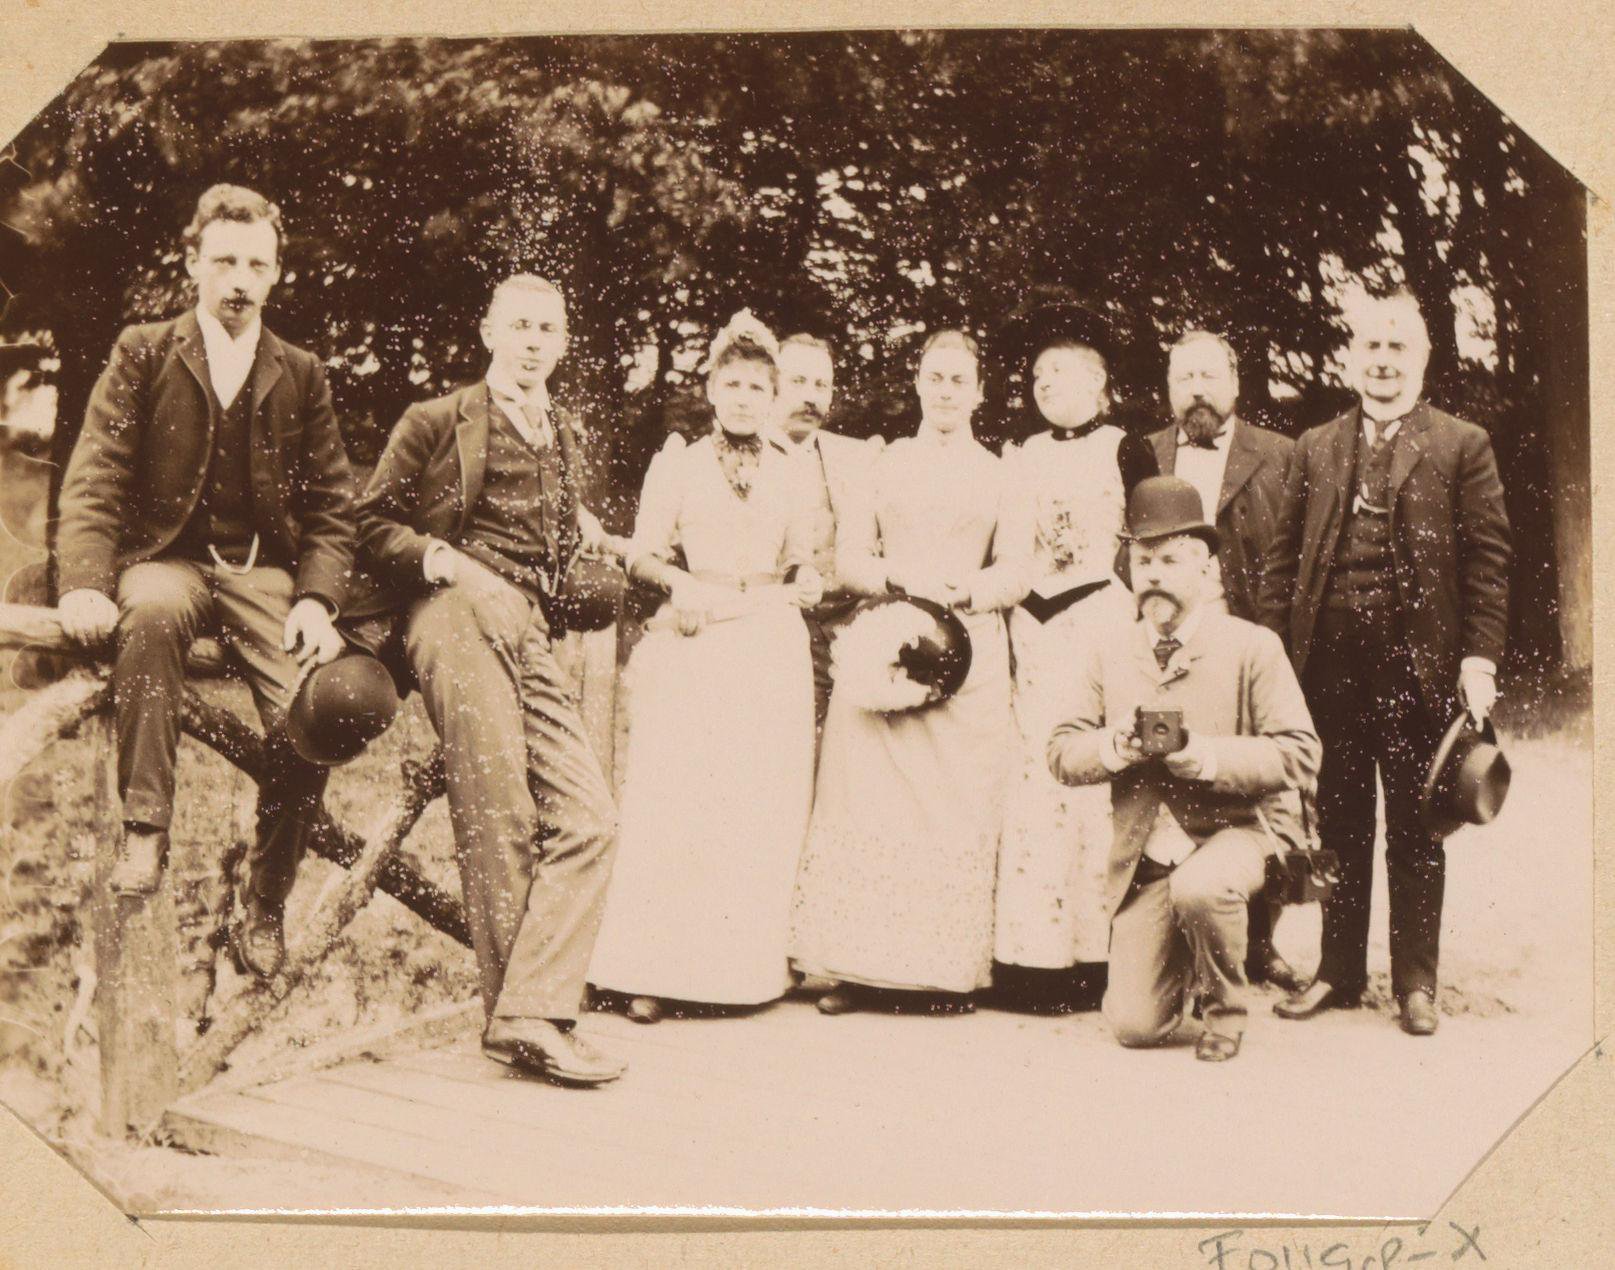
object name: photograph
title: Groepsportret van de familie Piek, knielend met Kodak No. 1 camera op de voorgrond is vermoedelijk Willem Frederik Piek Sr.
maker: johanna margaretha piek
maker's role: fotograaf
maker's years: 1870-1947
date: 1889-1893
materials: paper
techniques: gelatin silver print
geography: netherlands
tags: willem frederik piek sr., family life, anonymous historical persons portrayed in a group, in a group-portrait, netherlands